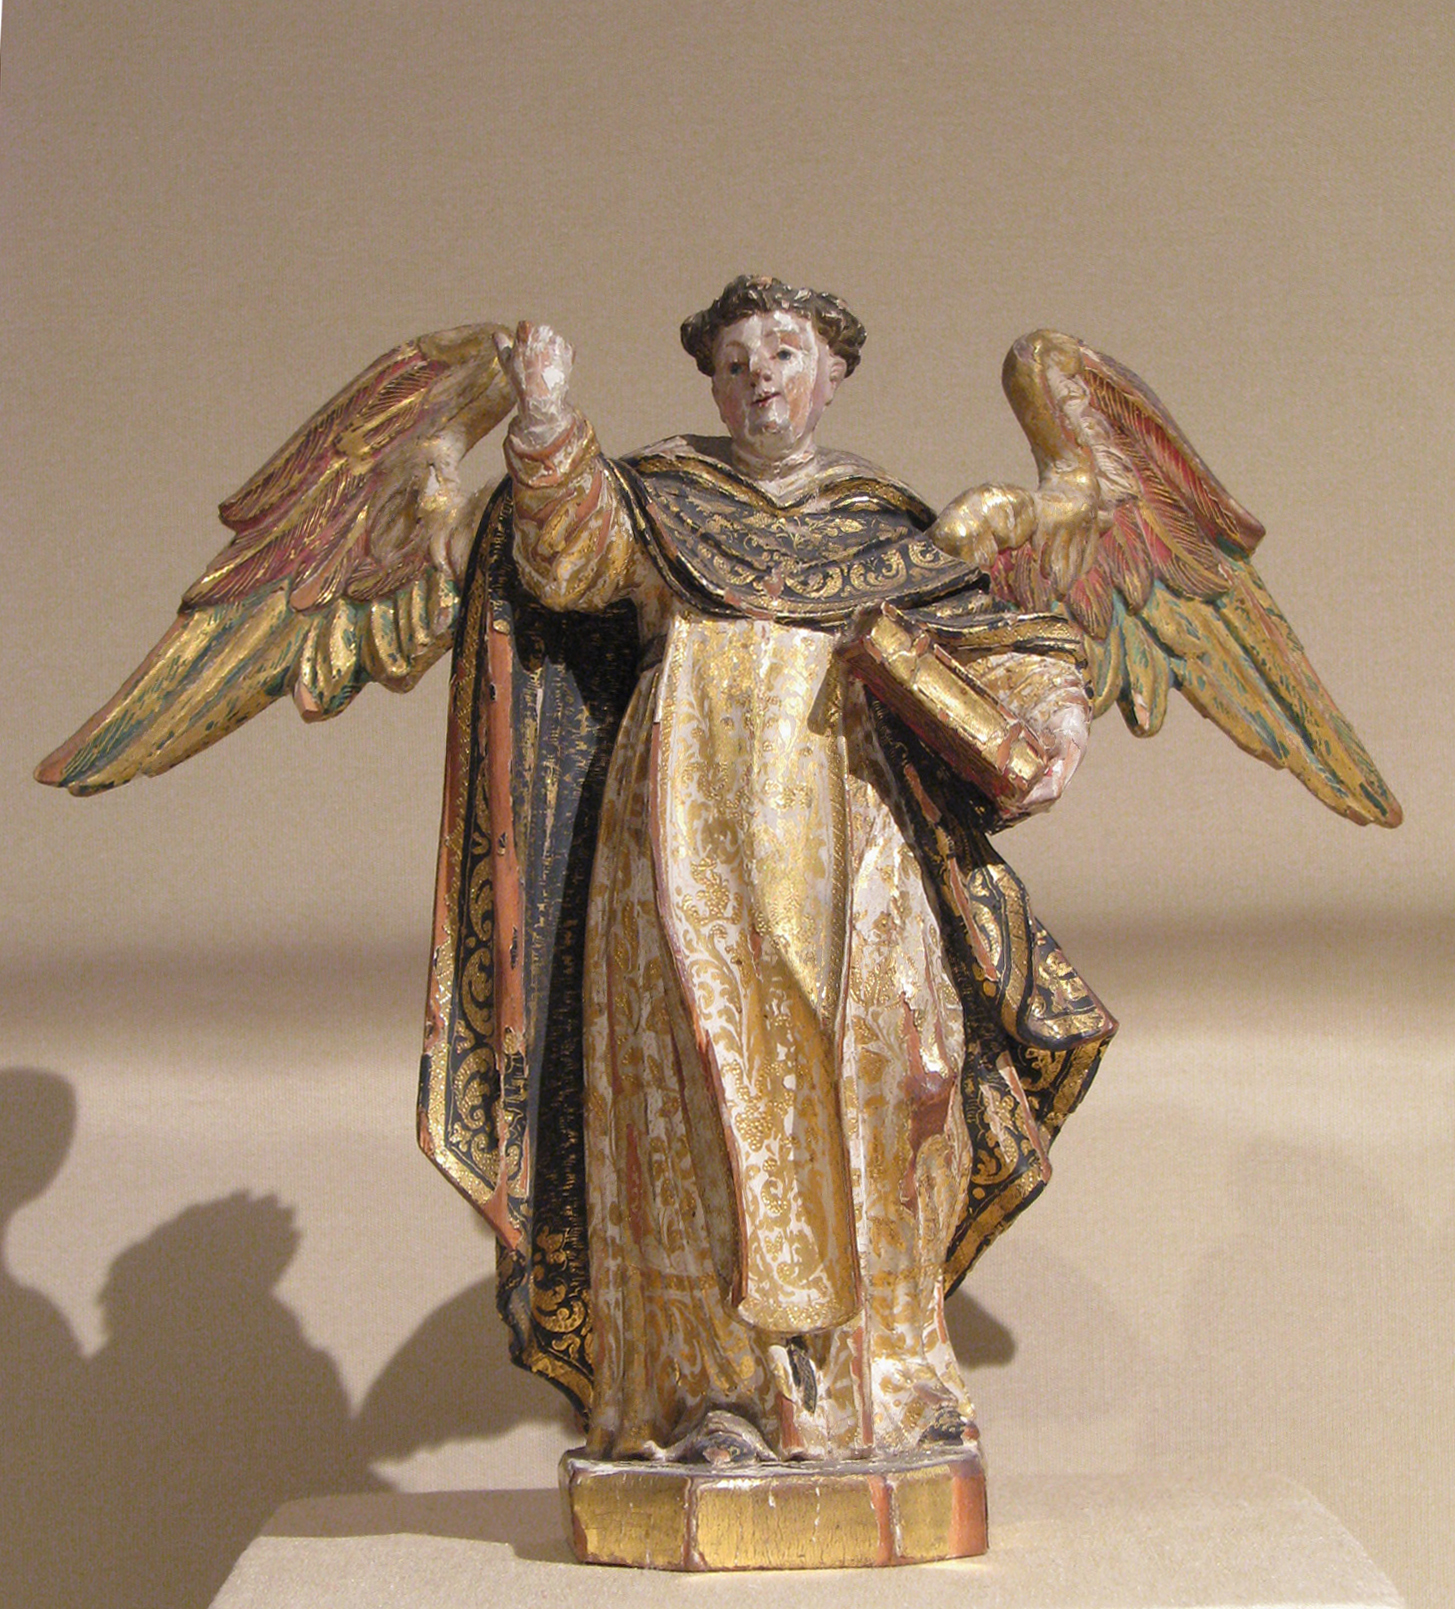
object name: statuette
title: Saint Vincent Ferrer (1350–1419)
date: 1667-1700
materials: wood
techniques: gilding, polychrome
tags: saints